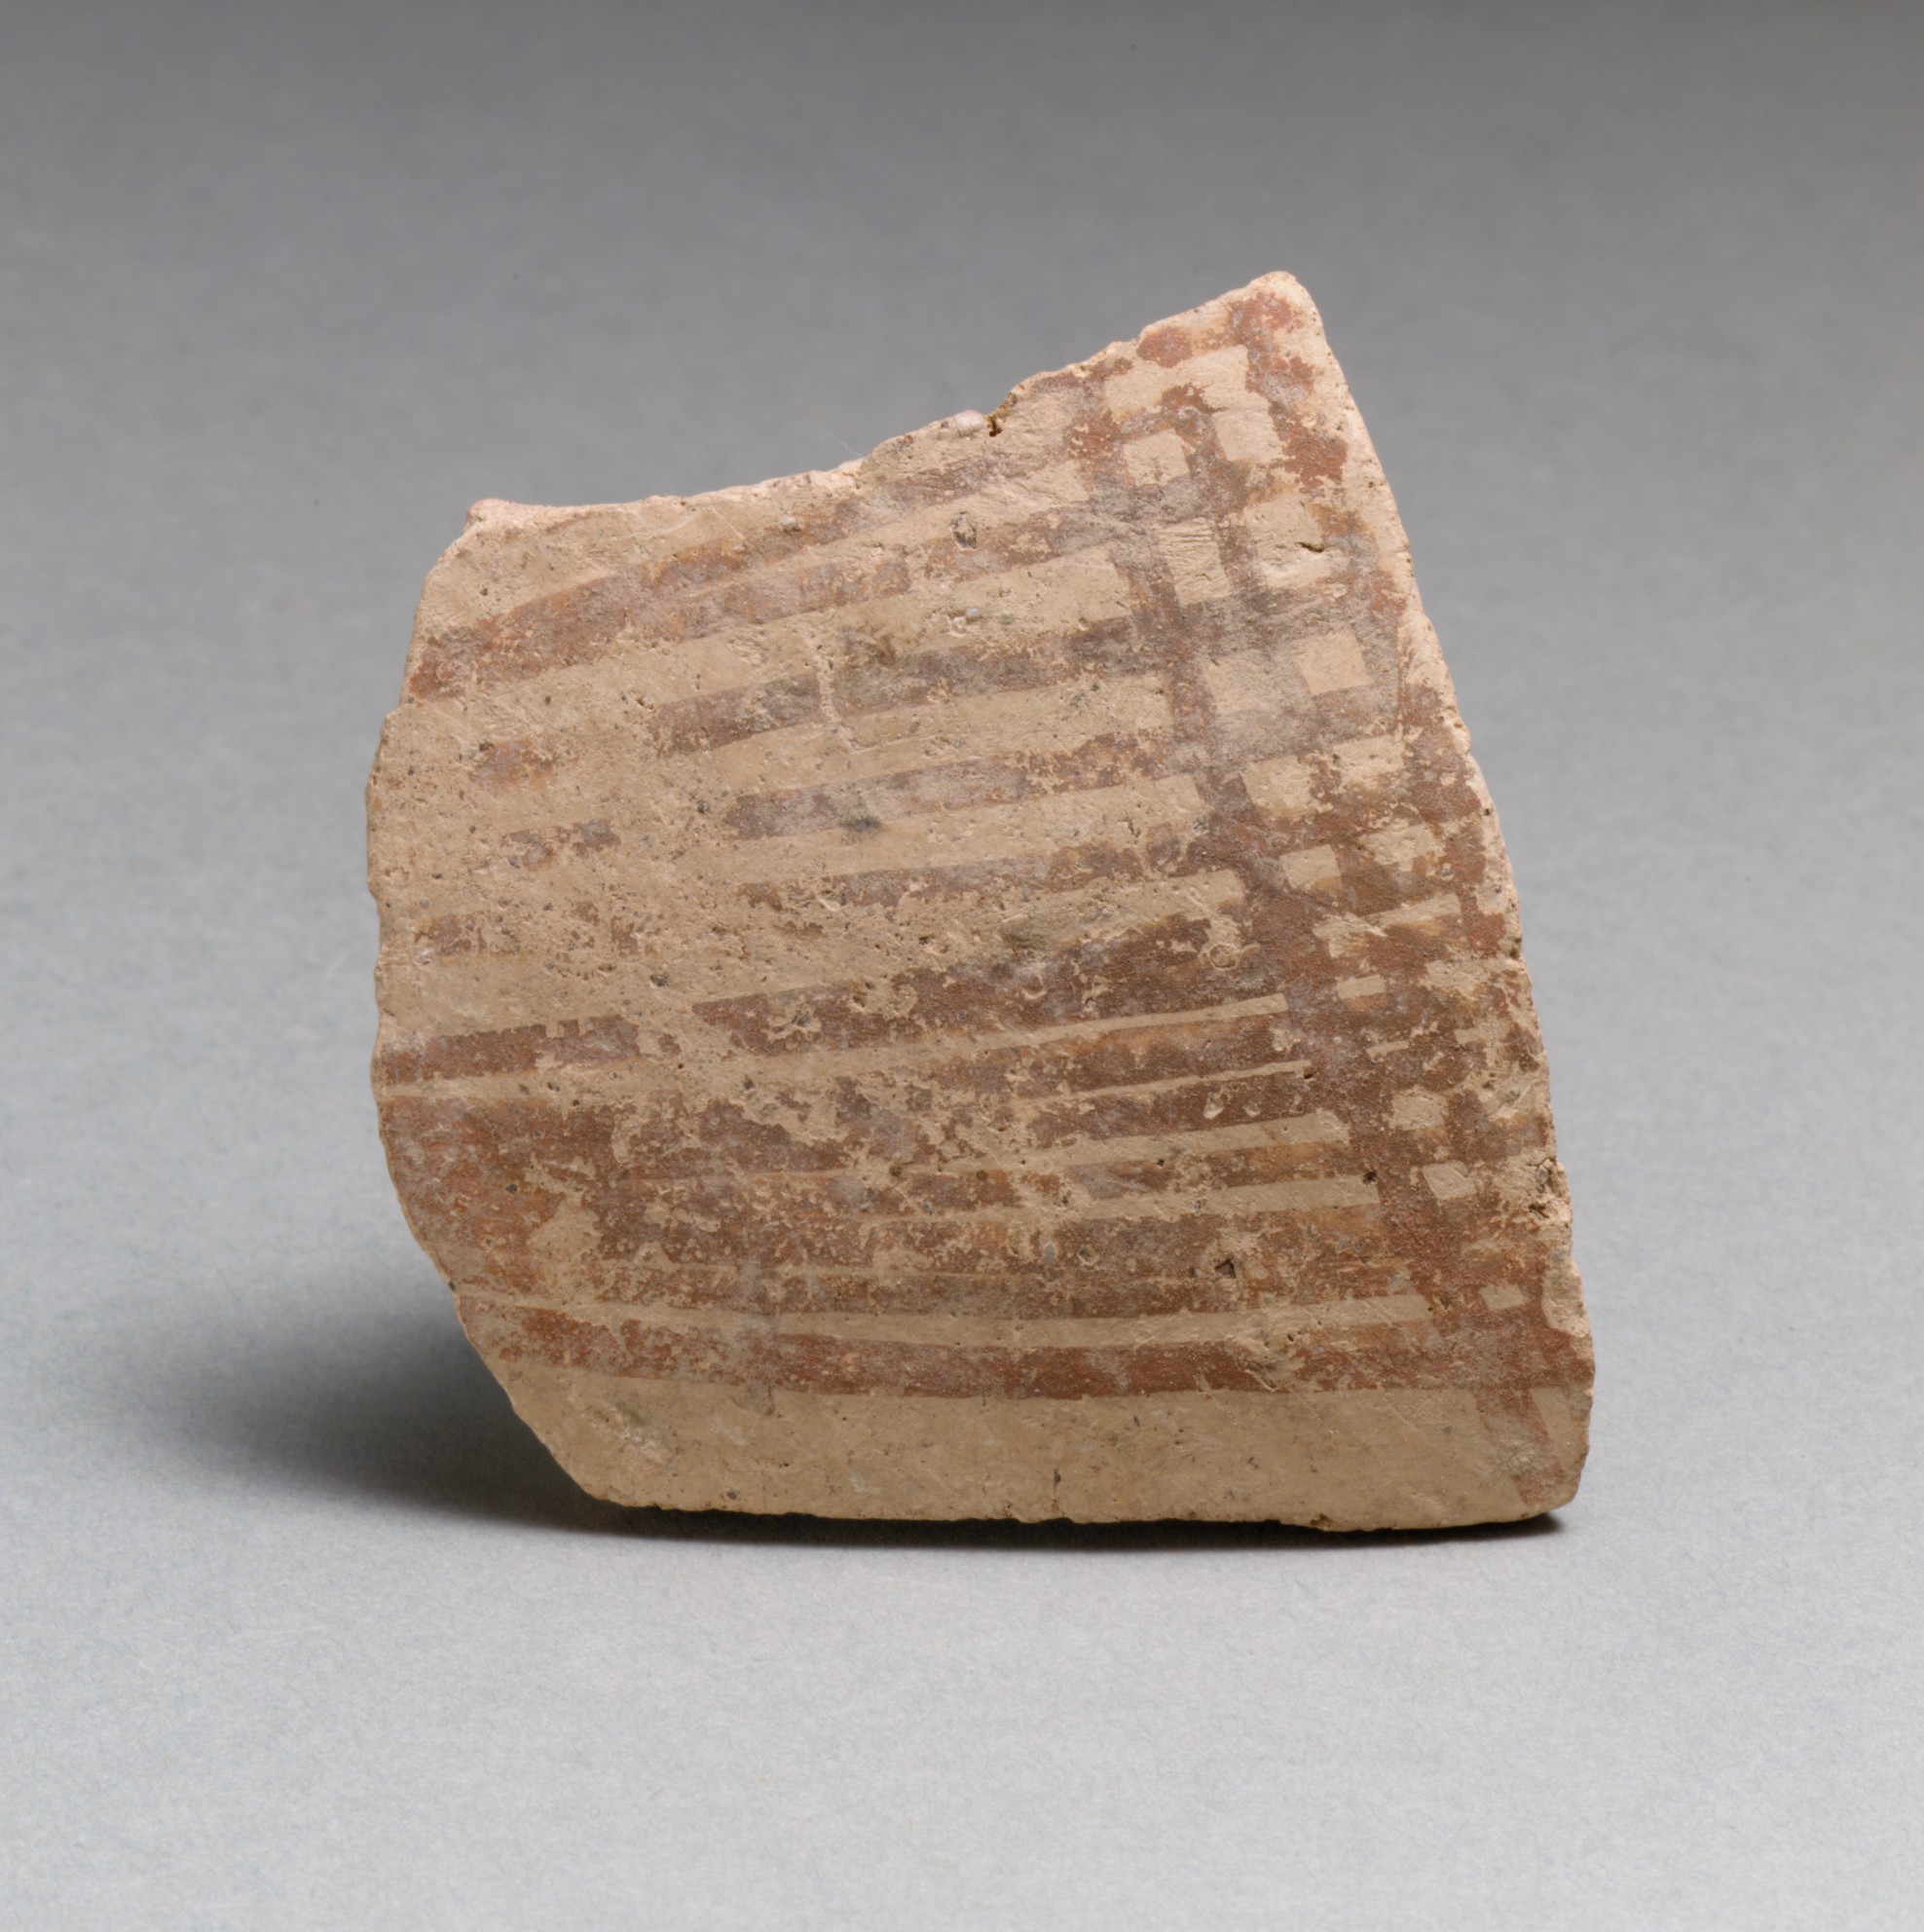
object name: vase fragment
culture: minoan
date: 2600-2000 BCE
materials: terracotta